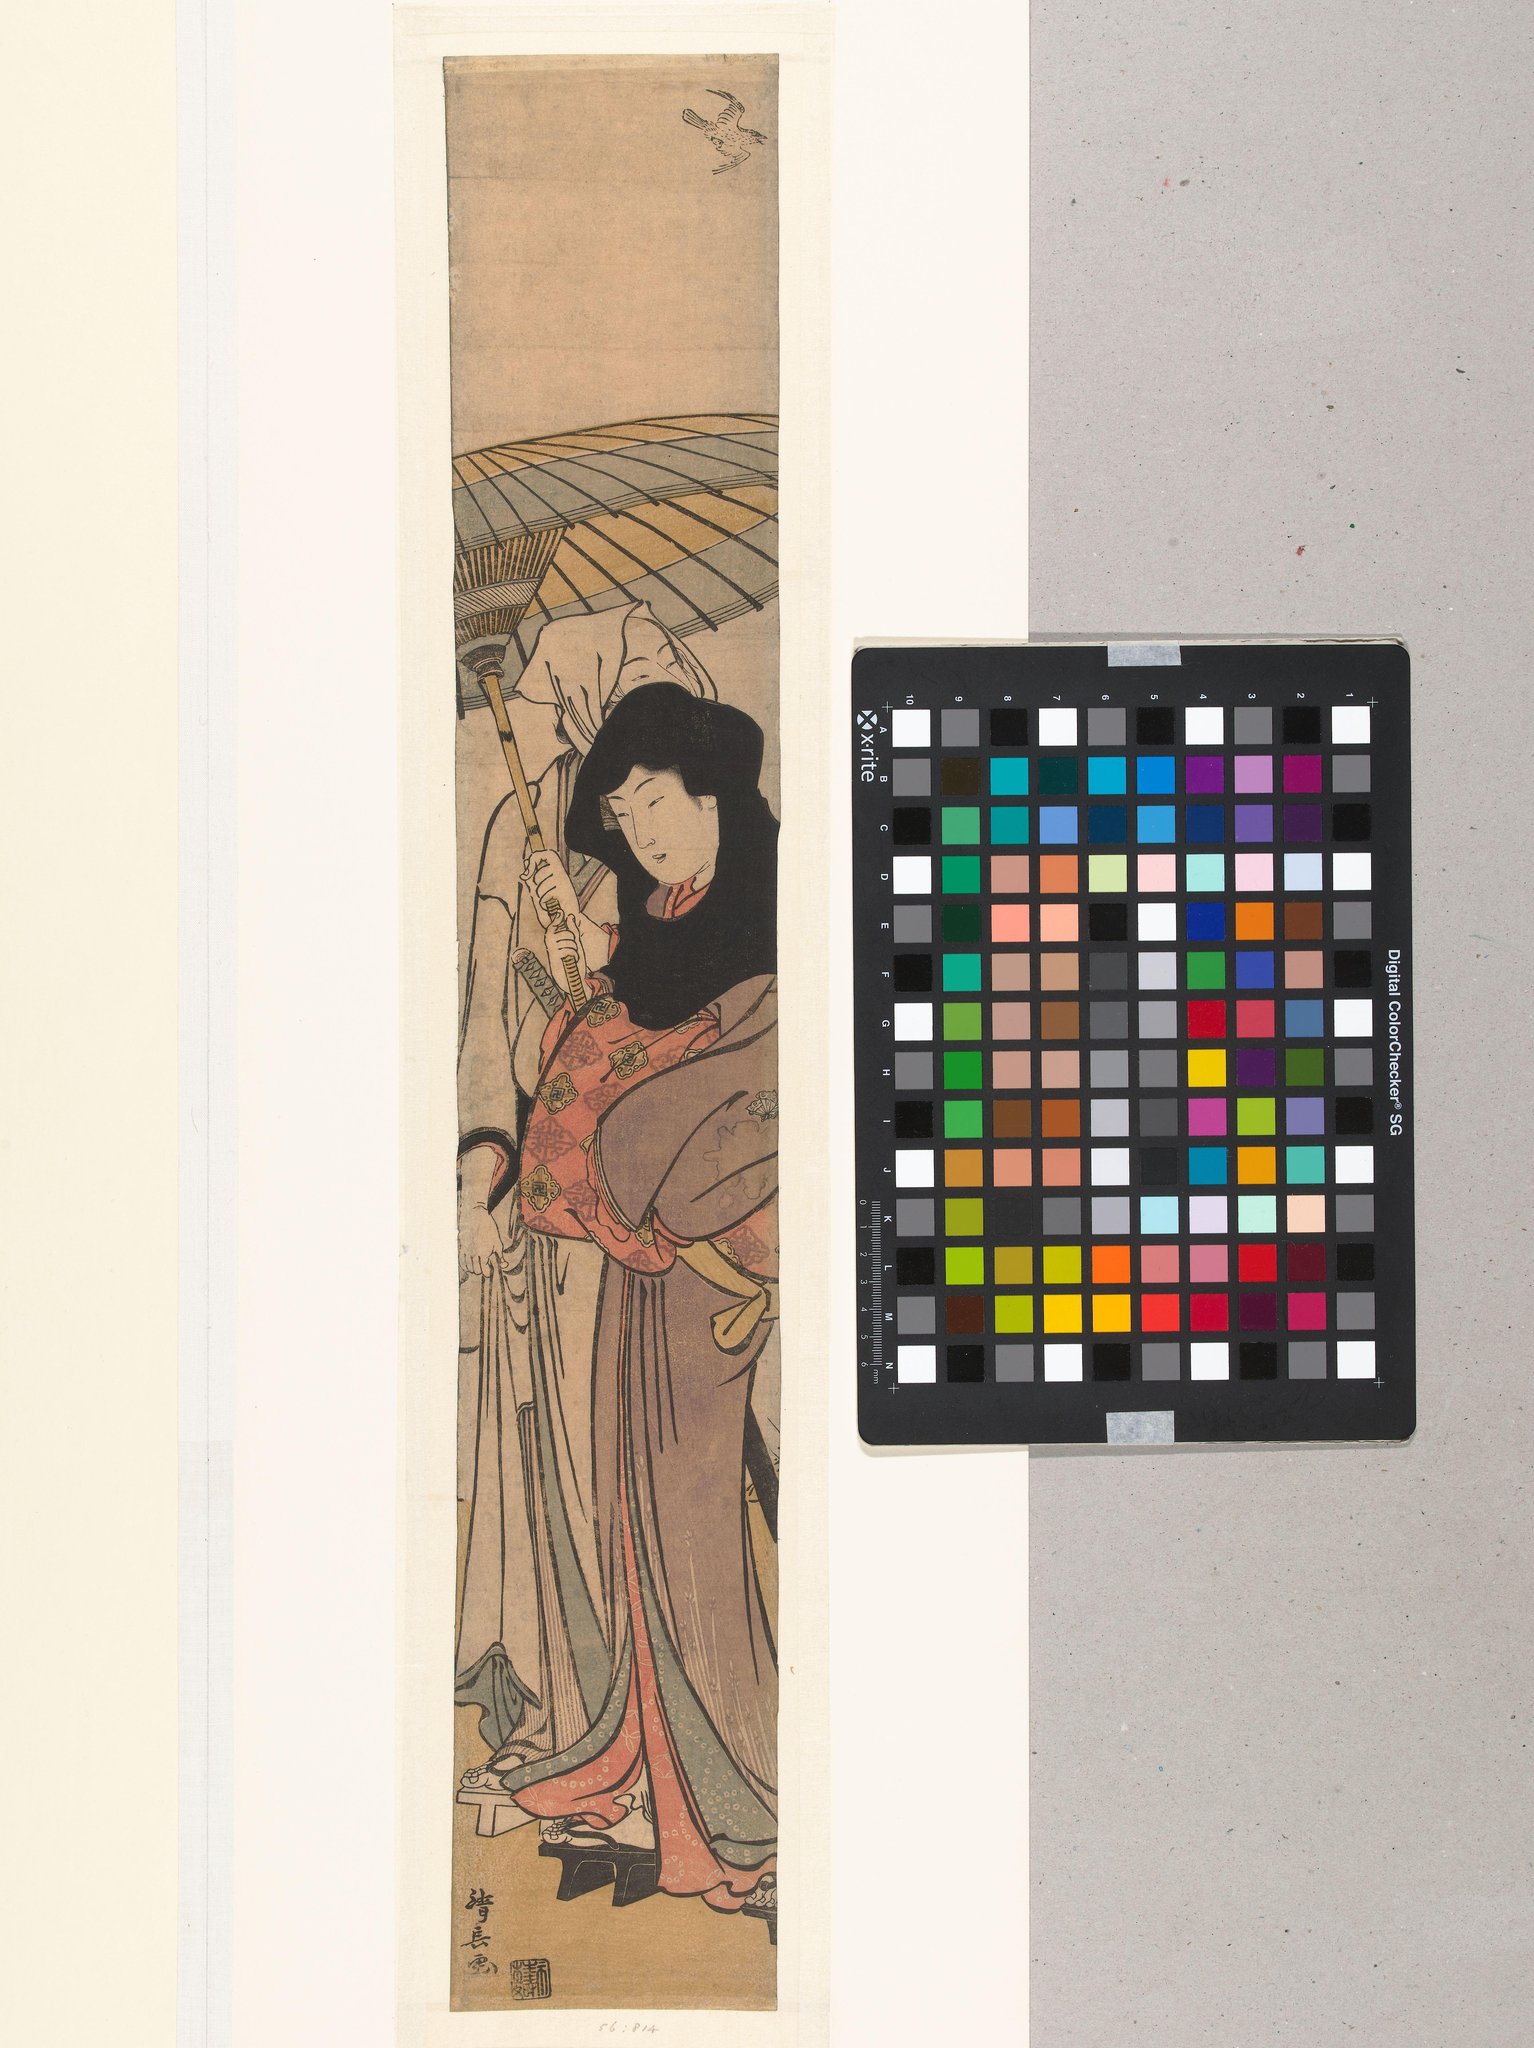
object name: print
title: Ochiyo en Hanbei nemen de benen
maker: torii kiyonaga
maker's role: draughtsman, print maker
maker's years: 1752-1815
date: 1780-1784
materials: paper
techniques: woodcut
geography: japan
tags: elopement, running away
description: Ochiya en haar man Hanbei, opkijkend naar een koekoek, onder een paraplu.